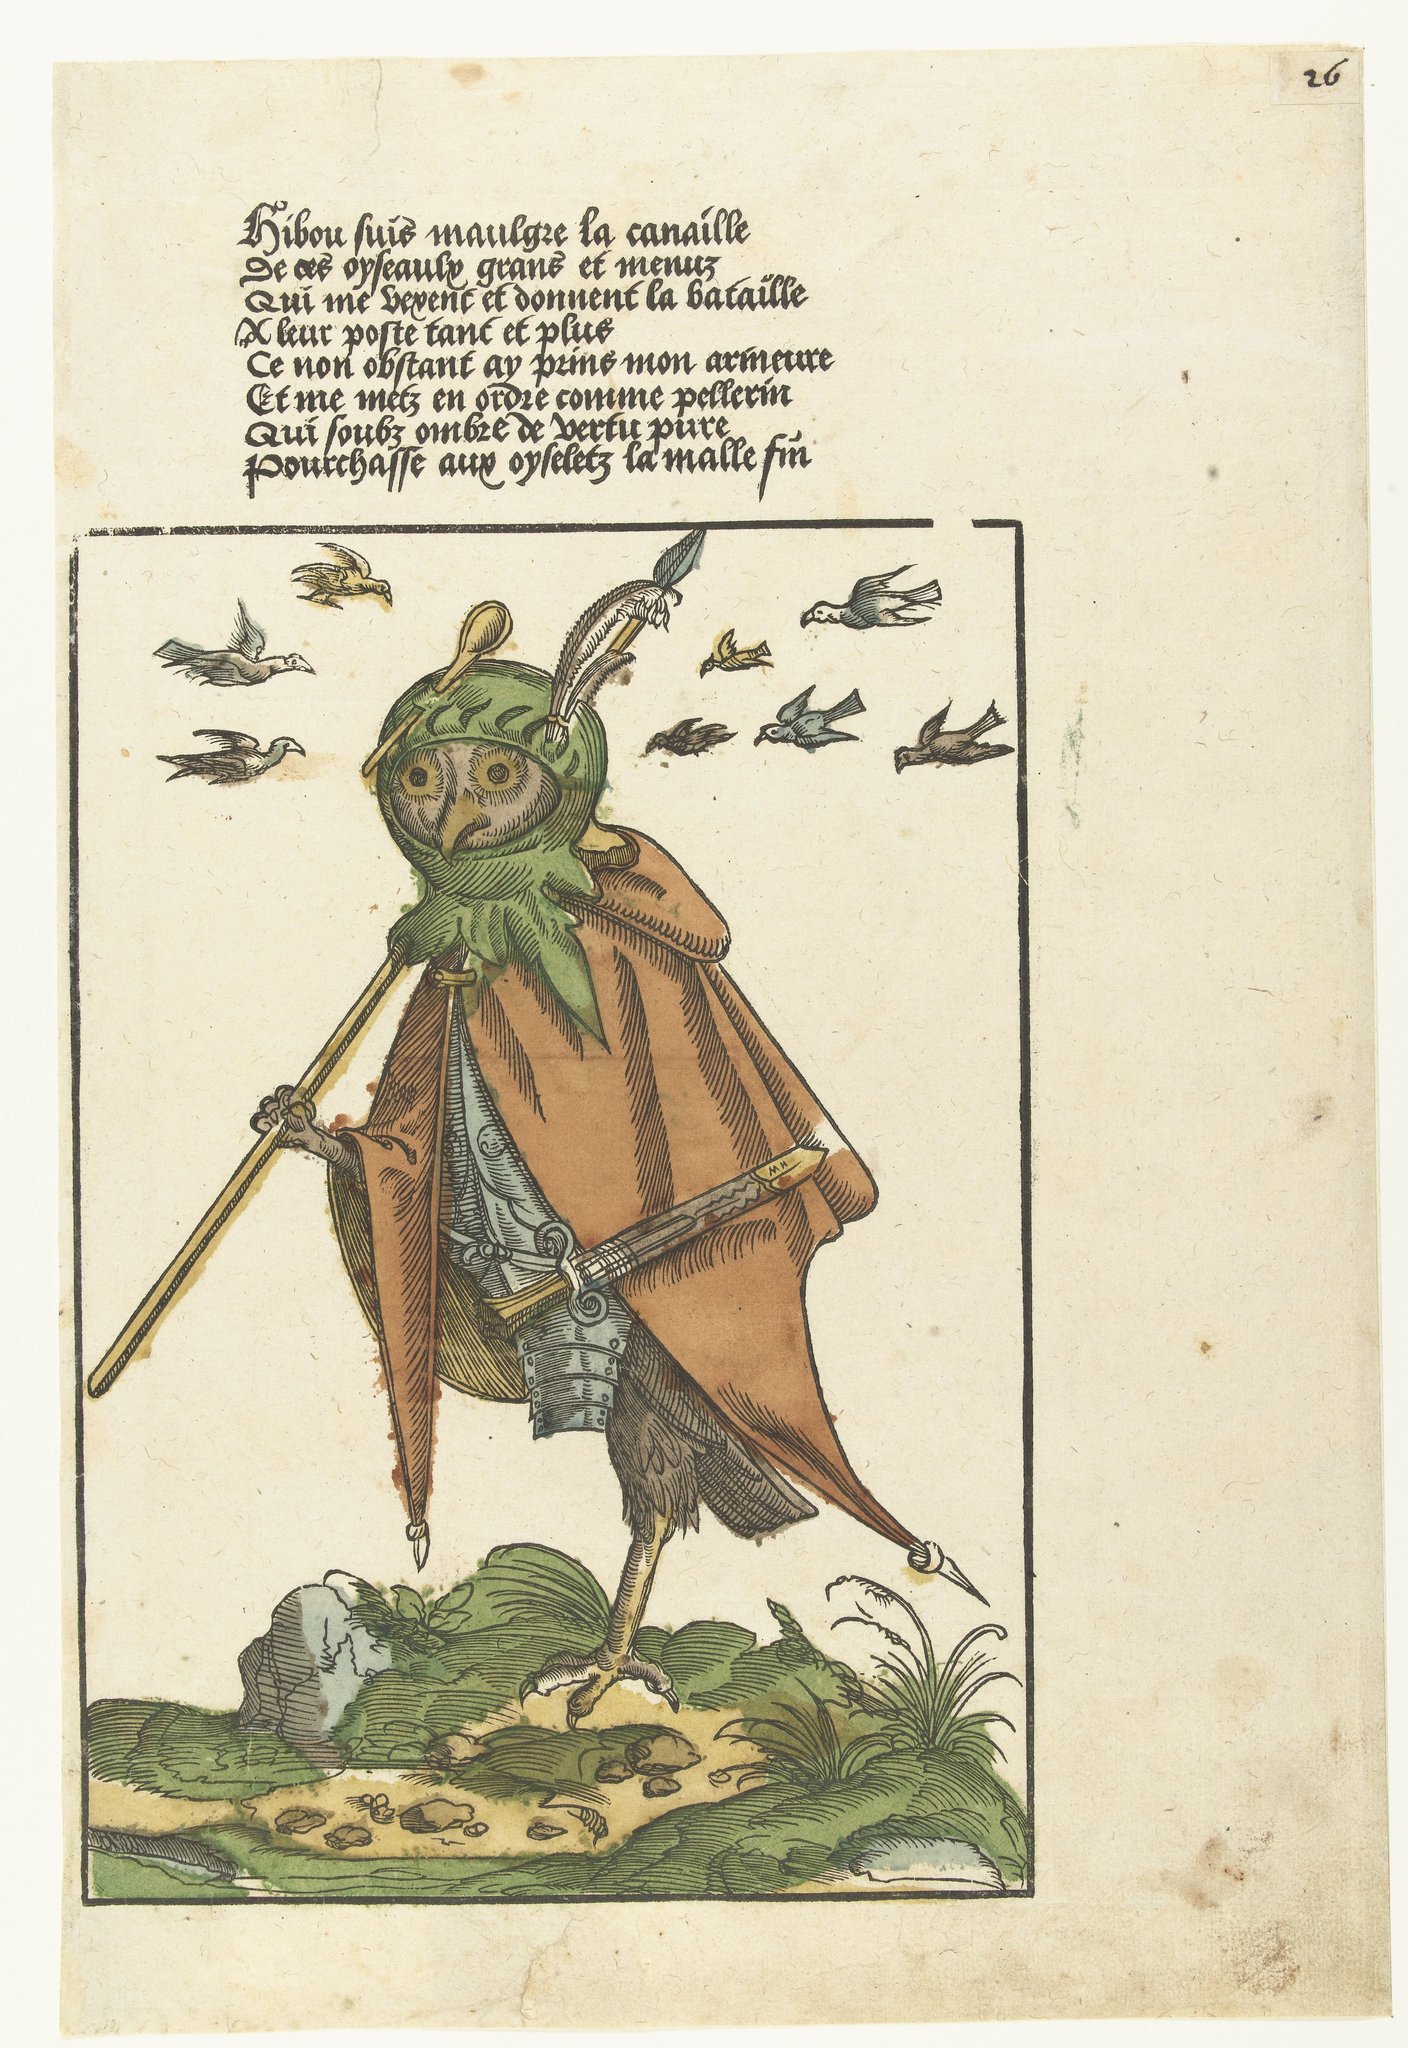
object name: print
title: Uil uitgedost als een soldaat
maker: monogrammist mh (graveur)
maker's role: print maker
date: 1500-1549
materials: paper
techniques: hand coloring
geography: low countries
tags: animals acting as human beings, owls, the soldier; the soldier's life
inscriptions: number: ‘26’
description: Uil, staand op één poot, aangekleed als soldaat, pollepel in muts gestoken. Acht vogels in de lucht. Achtregelige tekst in het Frans boven de afbeelding.